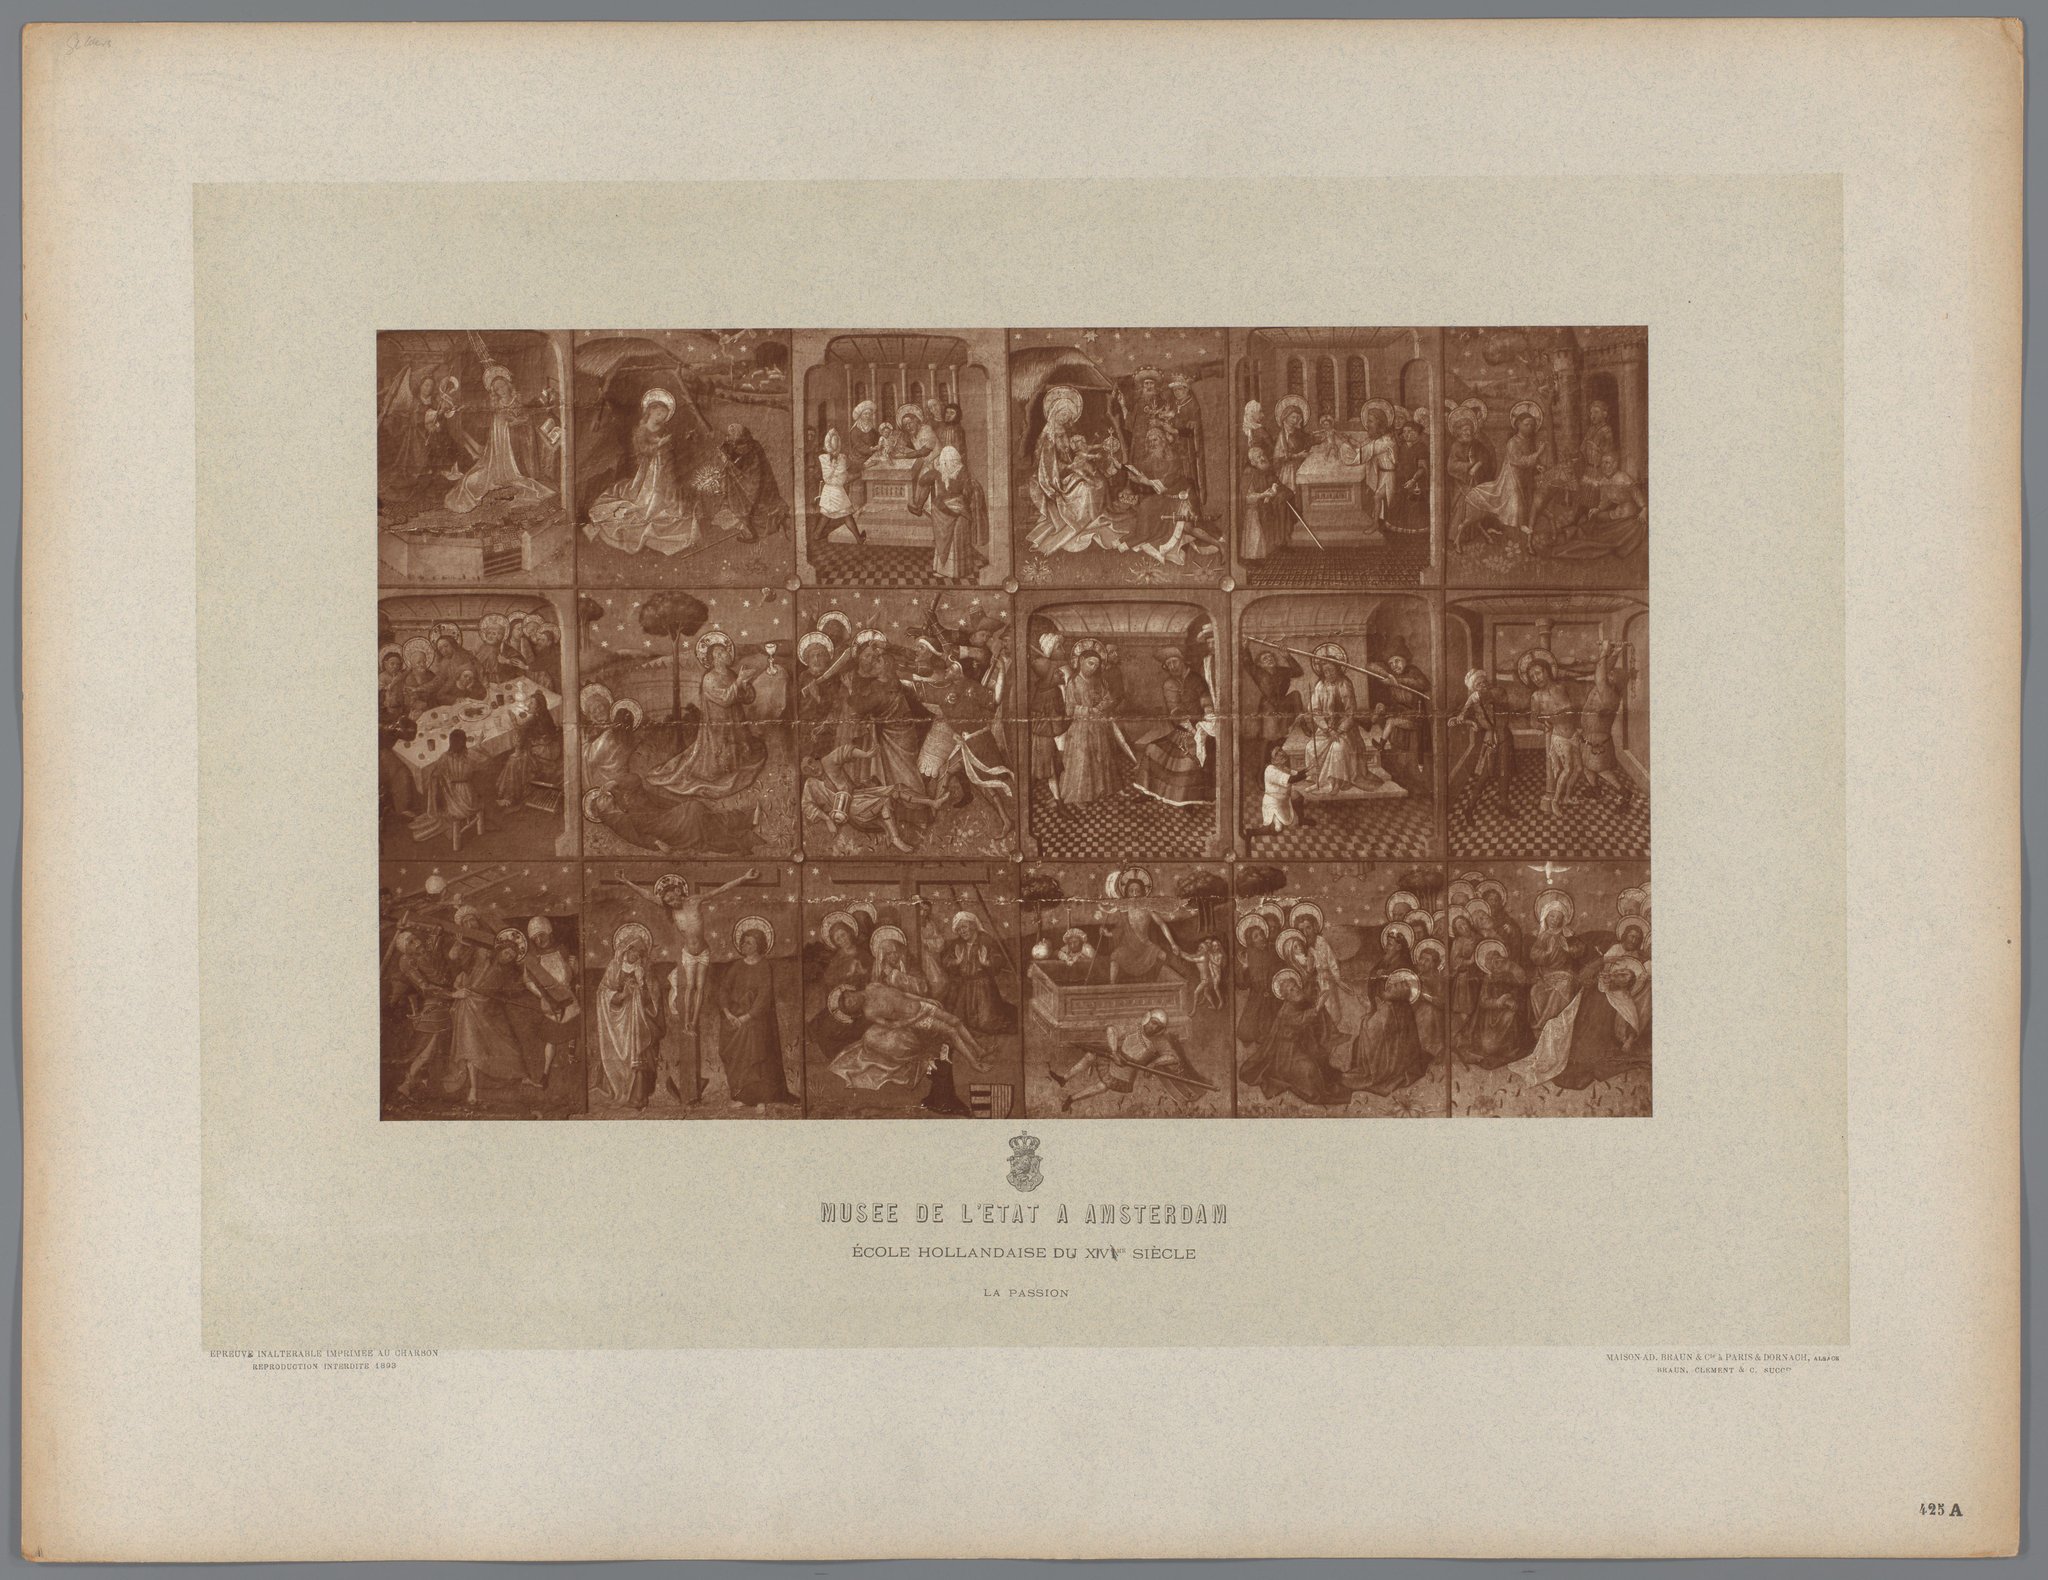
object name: photograph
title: Musée de l'Etat à Amsterdam/ Ecole Hollandaise du XIVme siècle/ La Passion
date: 1880-1900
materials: cardboard, paper, photographic support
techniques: carbon print